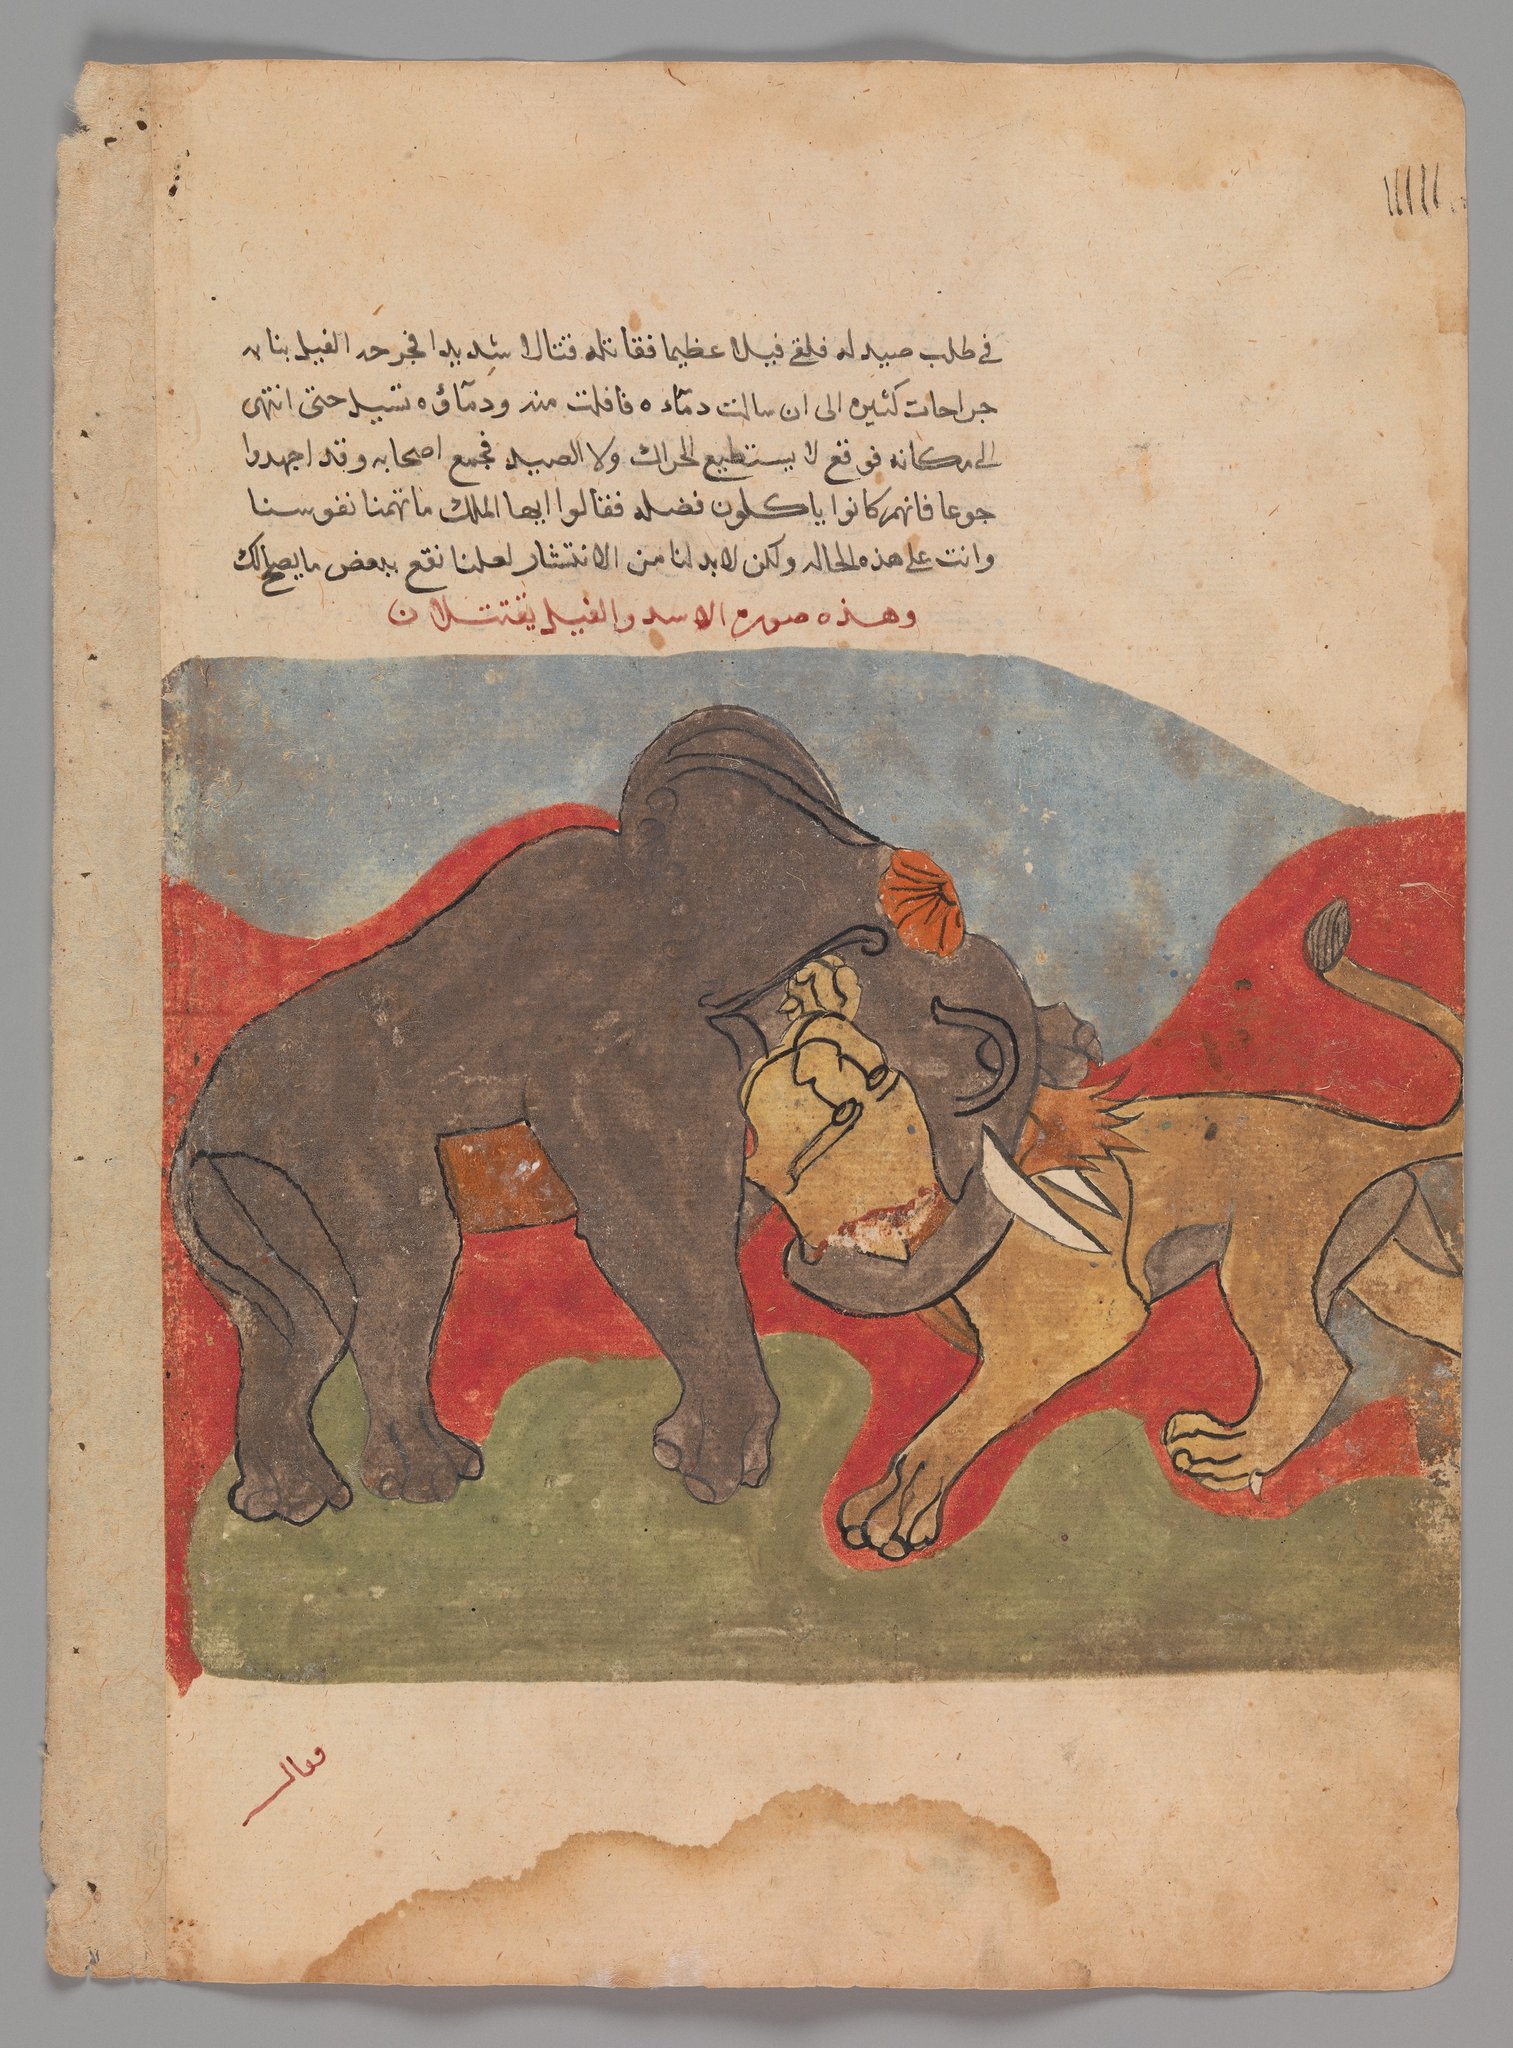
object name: folio from an illustrated manuscript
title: "The Lion and the Elephant Fighting", Folio from a Kalila wa Dimna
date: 1526-1550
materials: ink, paper, watercolor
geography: india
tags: elephants,lions